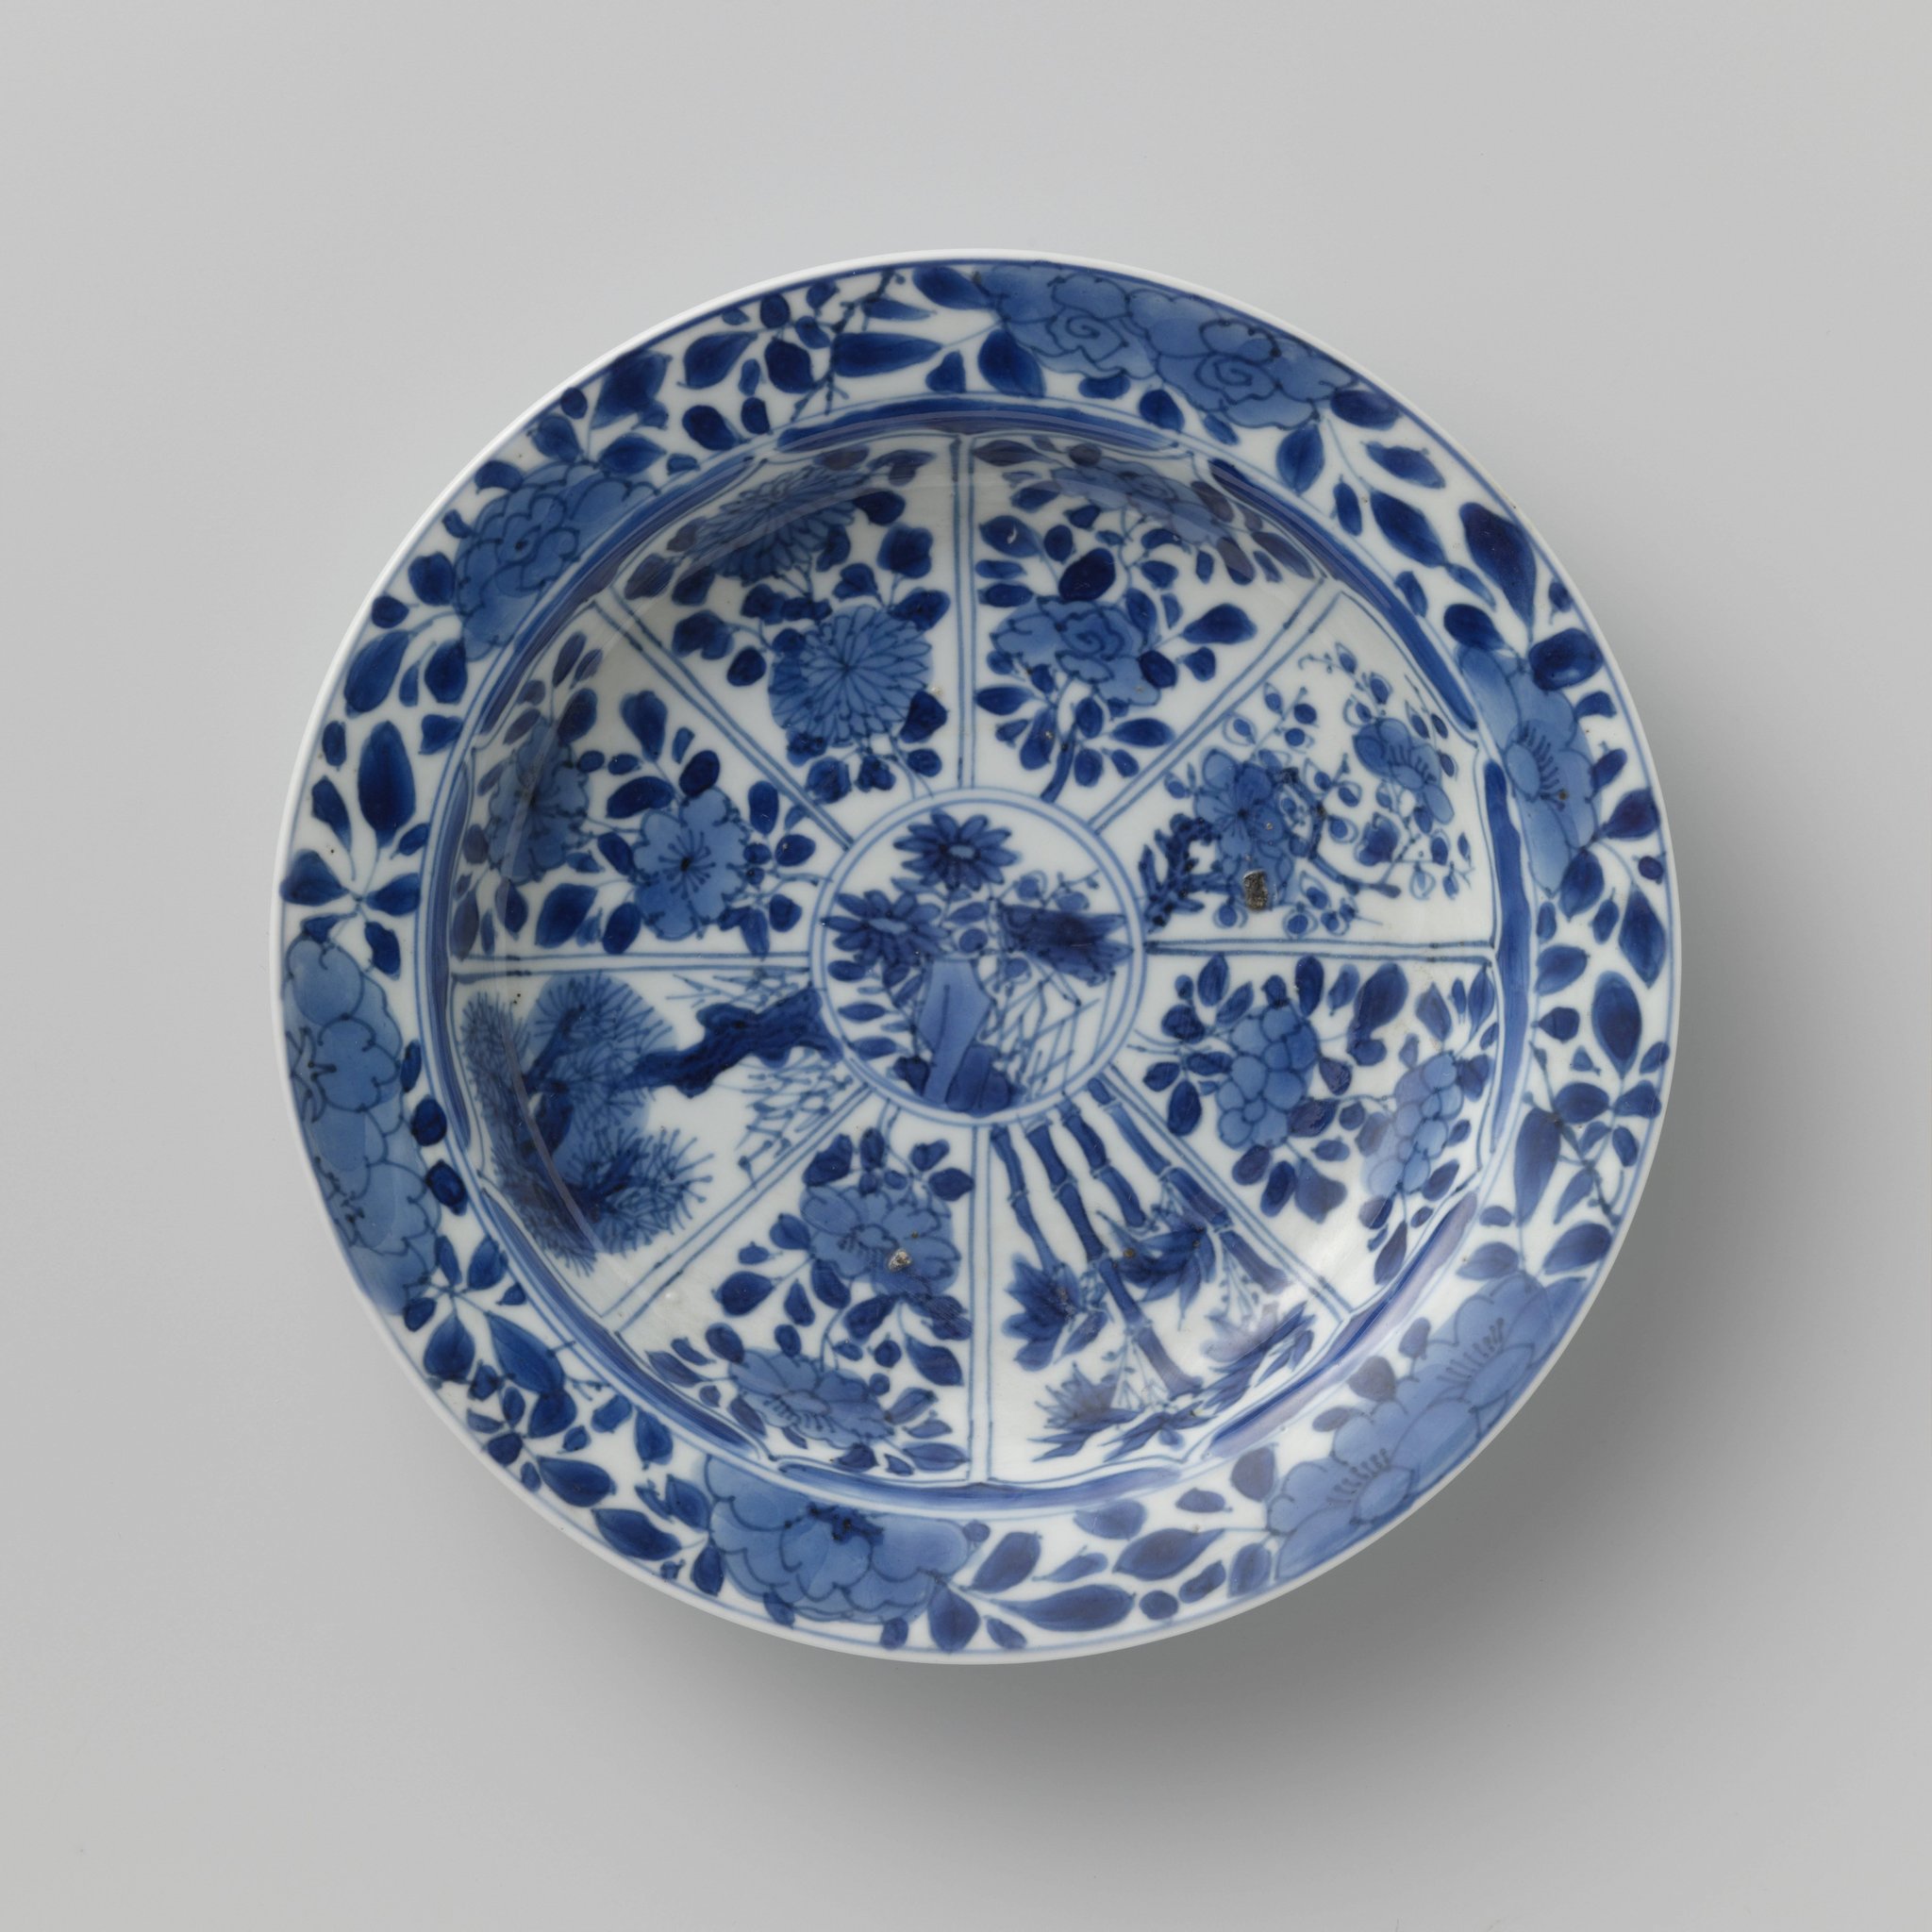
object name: platter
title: Saucer with panels in the shape of a flowerhead filled with flower sprays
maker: Anonymous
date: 1680-1720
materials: cobalt, glaze, paint, porcelain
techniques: firing, turning, vitrification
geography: china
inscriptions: mark